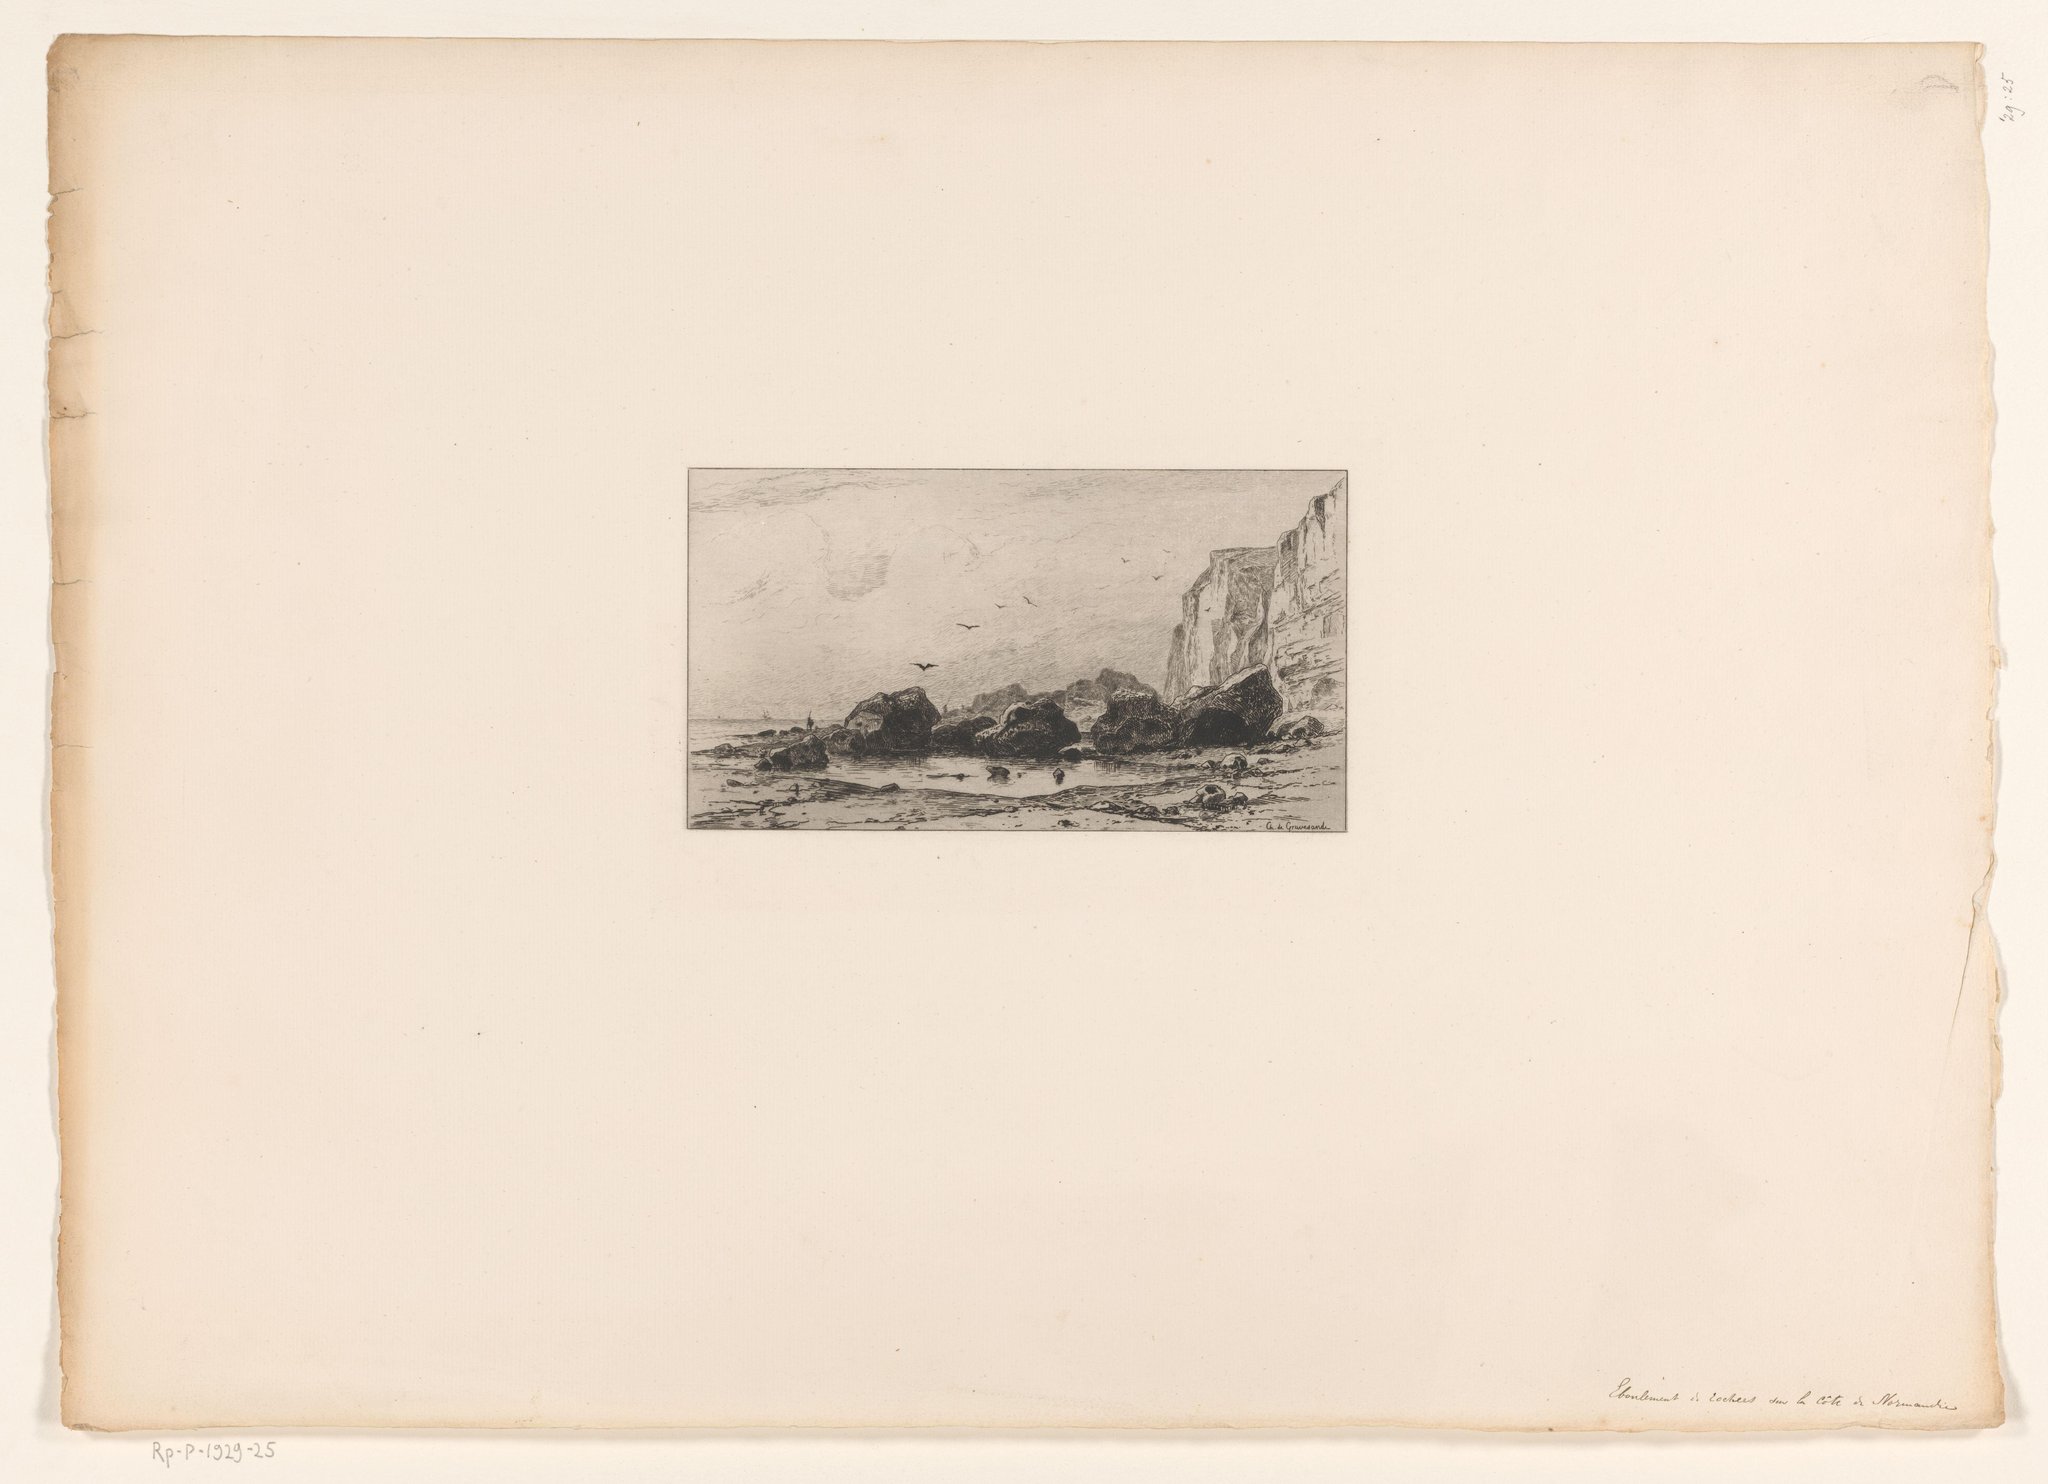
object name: print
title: Rotsen aan de kust van Normandië, bij Veules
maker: carel nicolaas storm van s-gravesande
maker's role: draughtsman, print maker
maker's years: 1841-1924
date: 1851-1924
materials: paper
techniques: etching, intaglio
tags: rocky coast, coastal cliff or crag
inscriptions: : ‘Eboulement de rochers du la côte de Normandie’, collector's mark: Lugt 2233, collector's mark: Lugt 2228